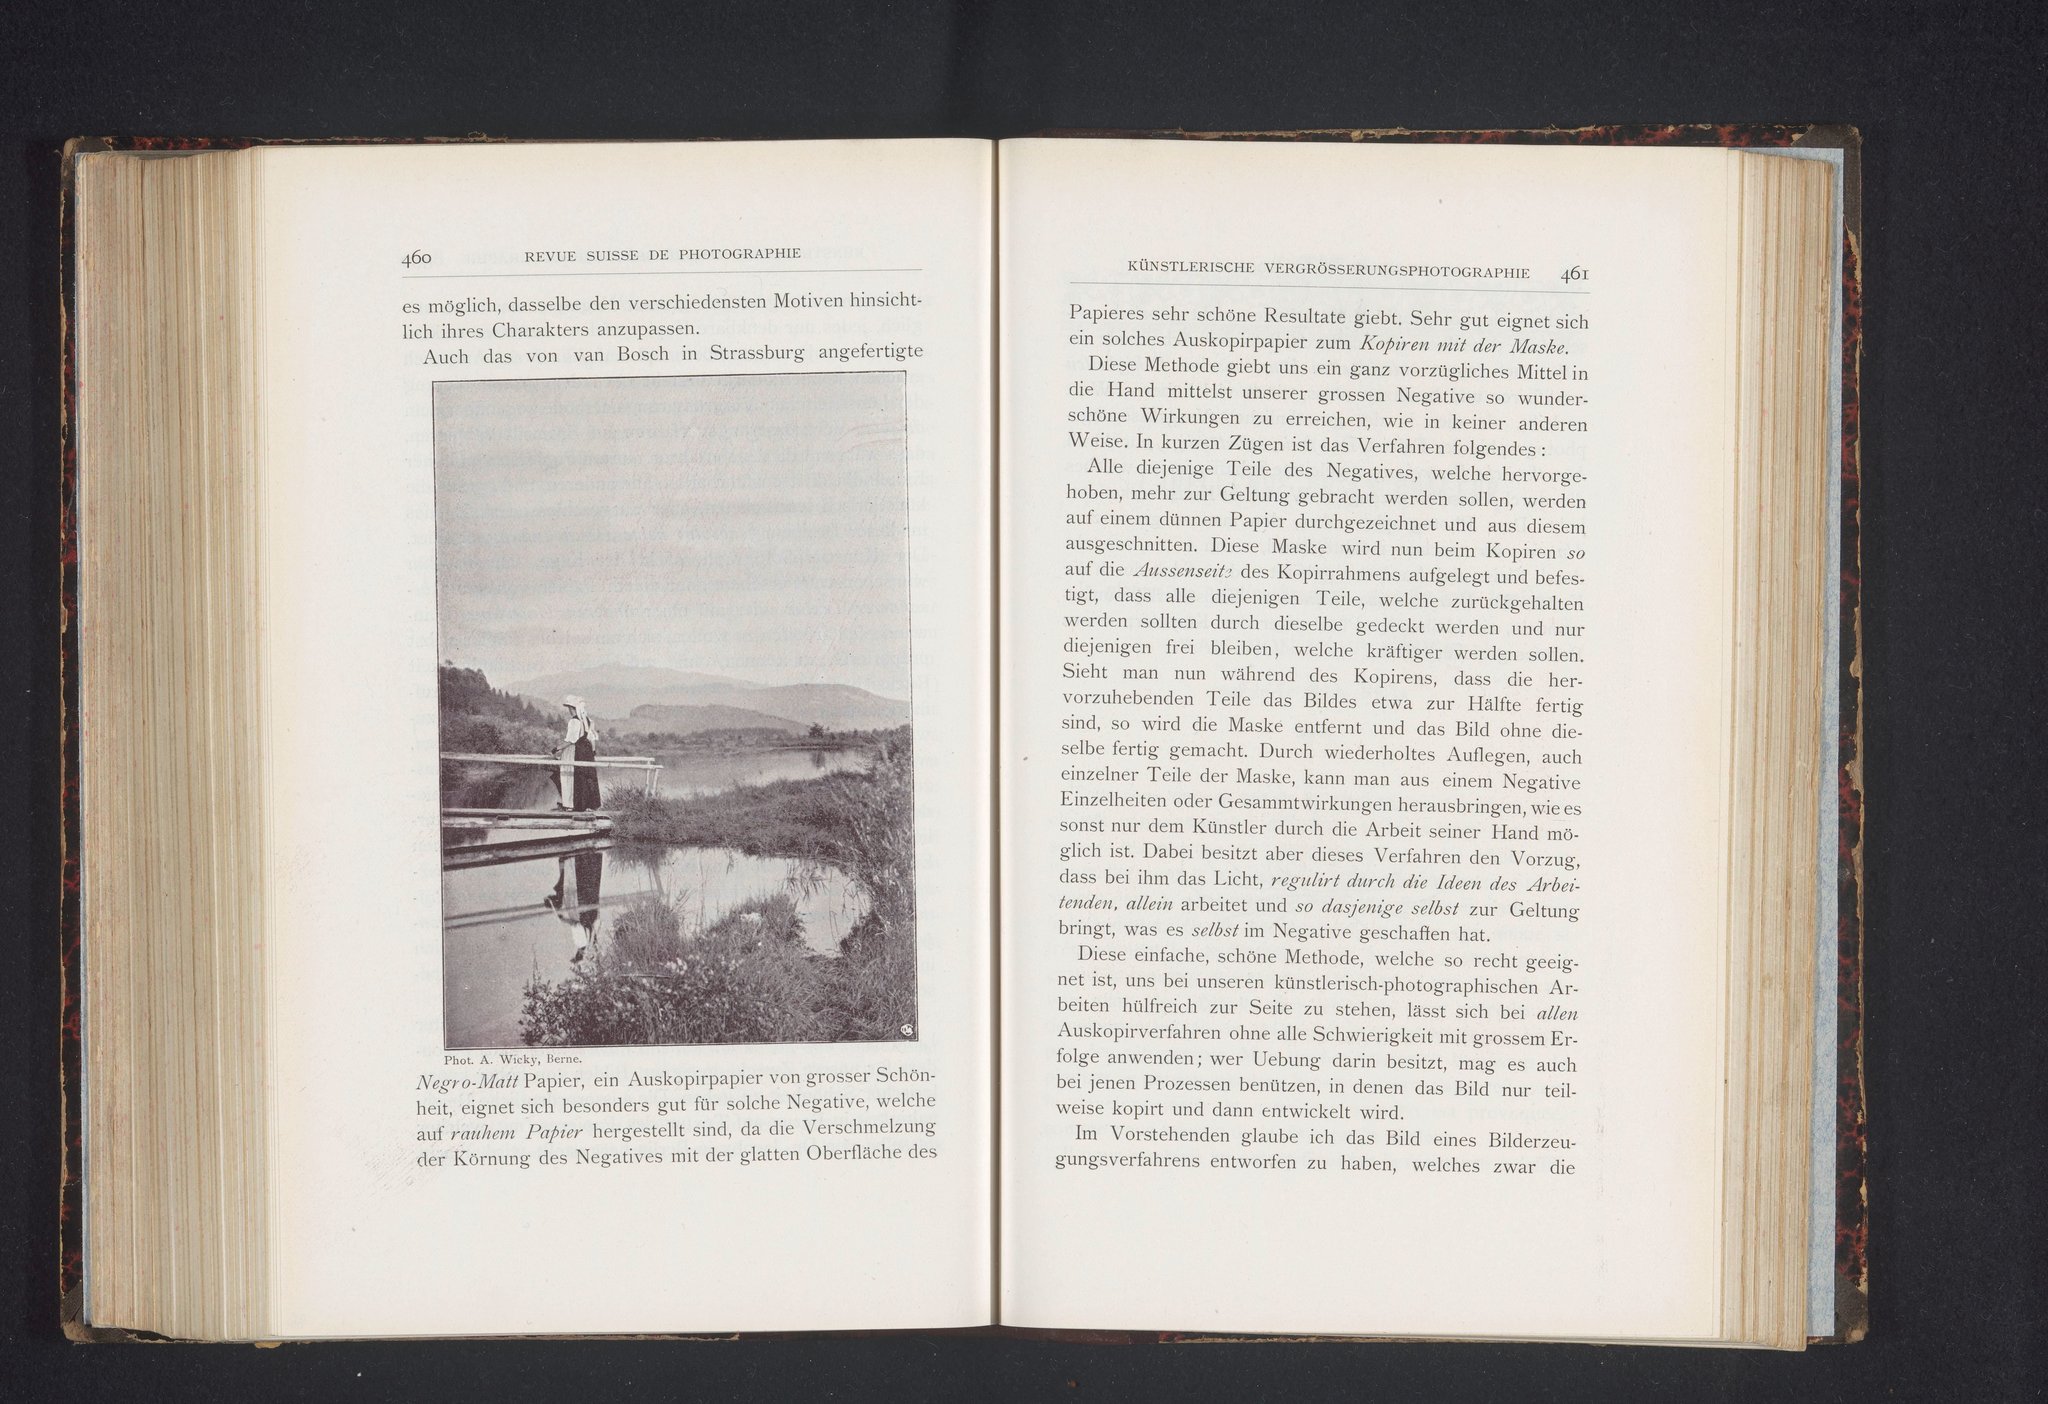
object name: page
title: Landschap met een vrouw op een brug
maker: a. wicky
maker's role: fotograaf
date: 1897-1902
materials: paper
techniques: autotype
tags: historical persons - bb - woman, landscapes with waters, waterscapes, seascapes (in the temperate zone)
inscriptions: monogram: ‘C. Cie’